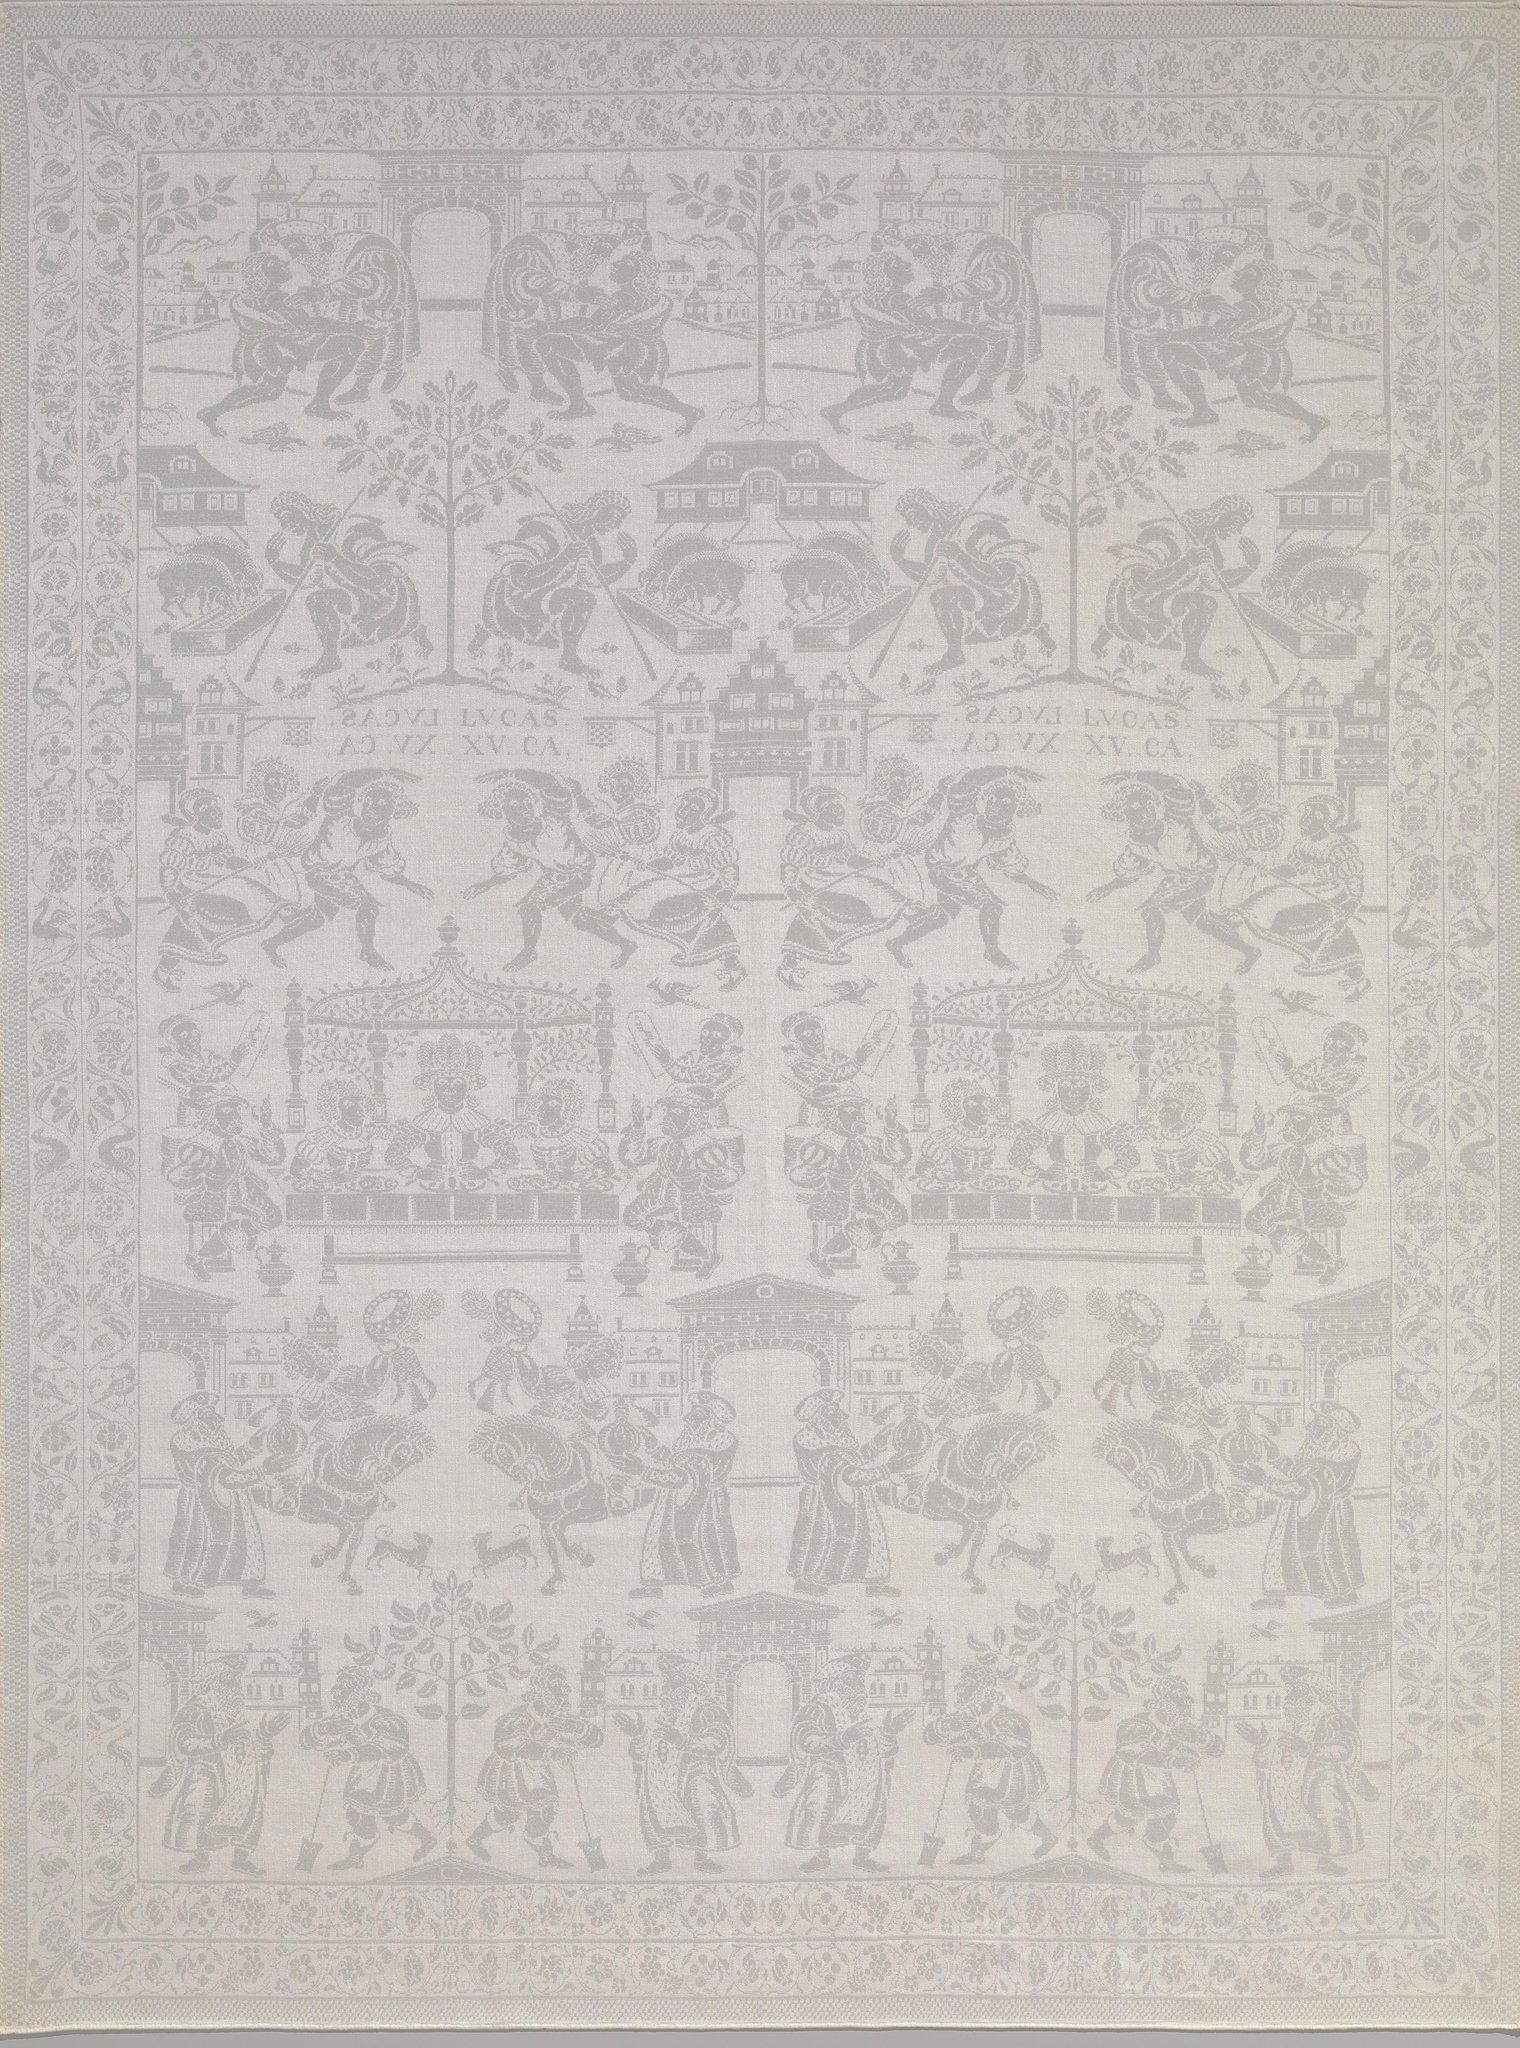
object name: napkin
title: Servet met de geschiedenis van de Verloren Zoon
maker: Anonymous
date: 1800-1899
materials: linen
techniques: damask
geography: brabant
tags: the parable of the prodigal son (luke 15:11-32)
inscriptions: mark: ‘B’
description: Servet van linnendamast met de geschiedenis van de Verloren Zoon. Middenveld: het symmetrisch verdubbelde patroon vertoont van onder naar boven zes taferelen: 1 De vader spreekt in de hof met de oudste zoon toe, 2 Voor de poort neemt de vader afscheid van zijn jongste zoon, die te paard is gezeten. 3 Het banket in het lustprieel. De zoon is gezeten achter een lange tafel te midden van vrouwen en kameraden. Op de achtergrond tekent de waardin de vertering op een lei aan. 4 De geplunderde jongeman wordt door twee vrouwen, onder andere met bezems, weggejaagd. Bijschrift LUCAS XV CAP. 5 De zoon eet op het erf uit een varkenstrog. 6 Voor de poort gaat de vader zijn boetvaardige zoon tegemoet. De vader is gekleed in 16e-eeuws kostuum: wijde herenmantel met liggende kraag, platte gevederde hoed en ingesnoerde ballonmouwen. Staande randen: symmetrisch verdubbelde en door een lijn gescheiden rank met bloemen, vruchten en diverse vogels; daarbuiten: blokkenrand.